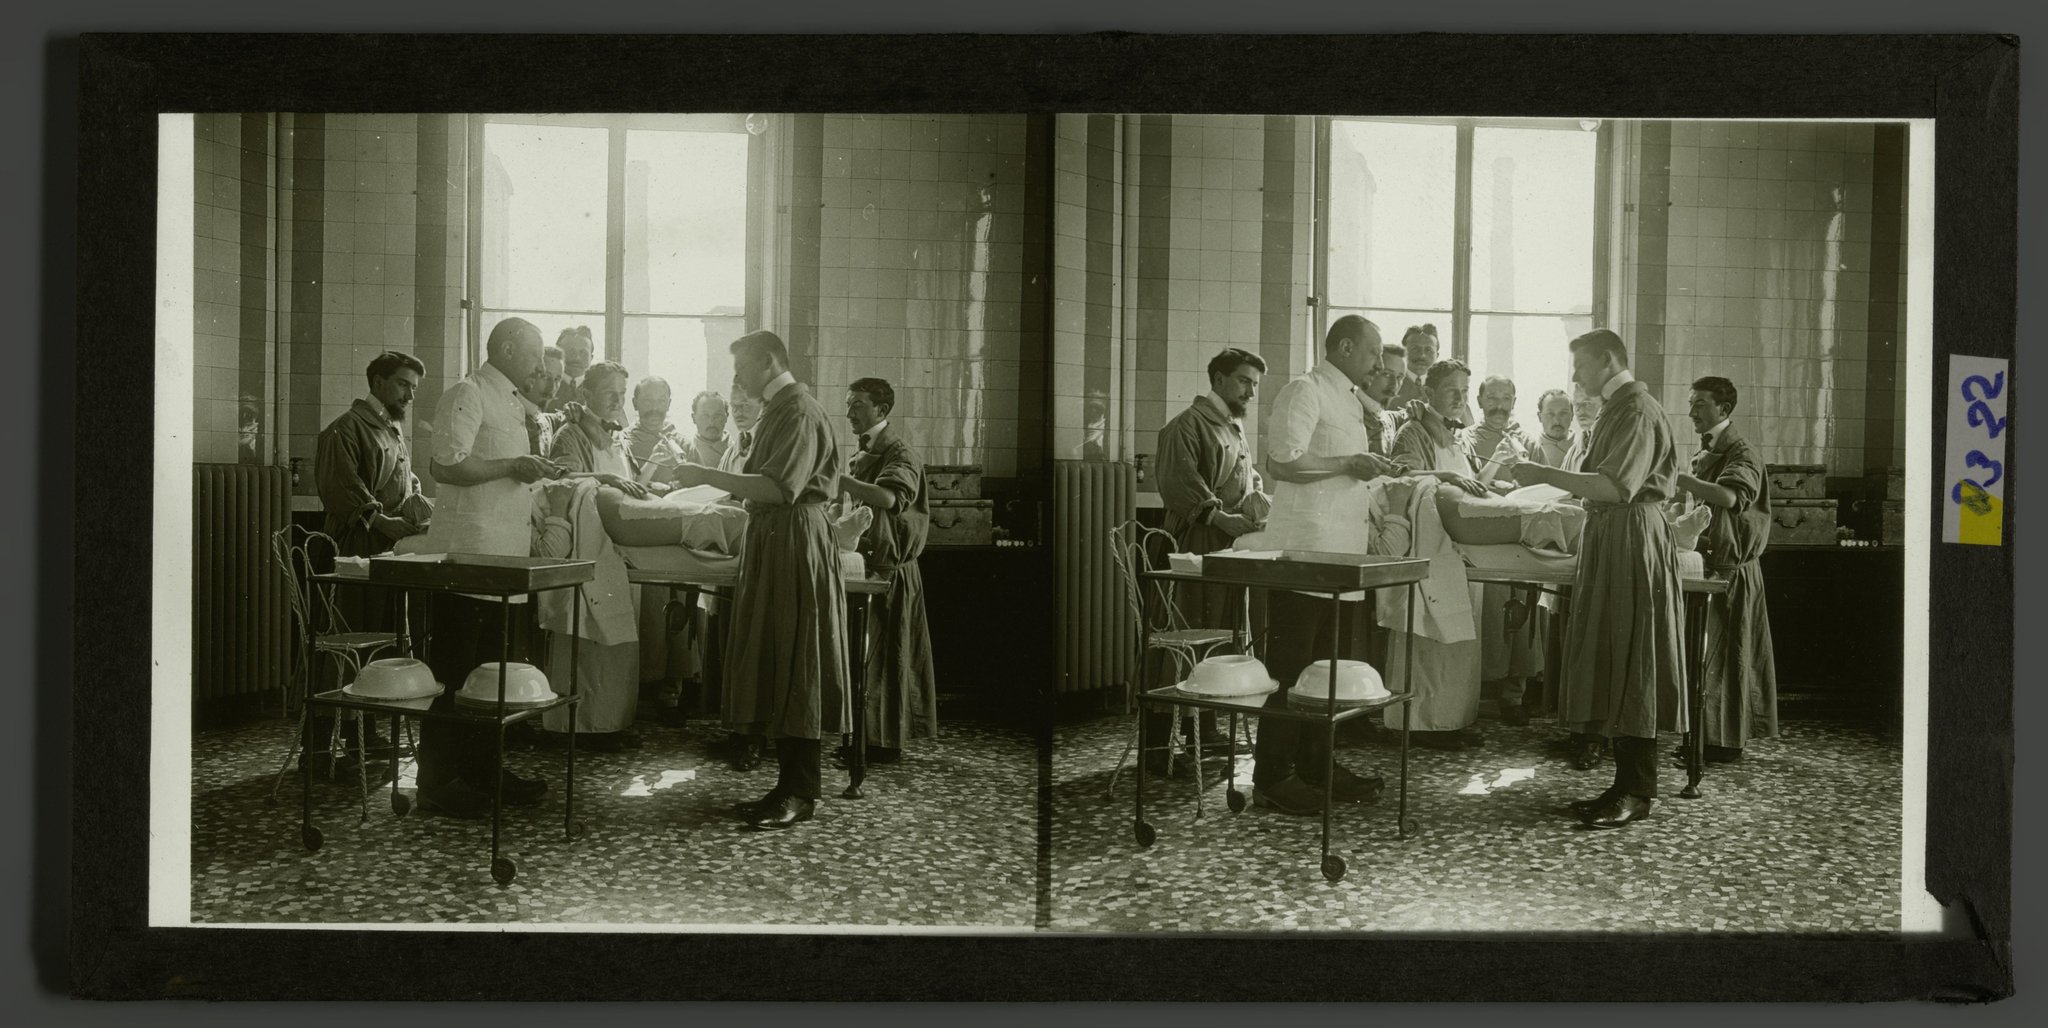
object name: stereoscopic photograph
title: Operatietafel tijdens operatie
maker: Anonymous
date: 1900-1920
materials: glass, paper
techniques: slide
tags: operating room, physician, doctor